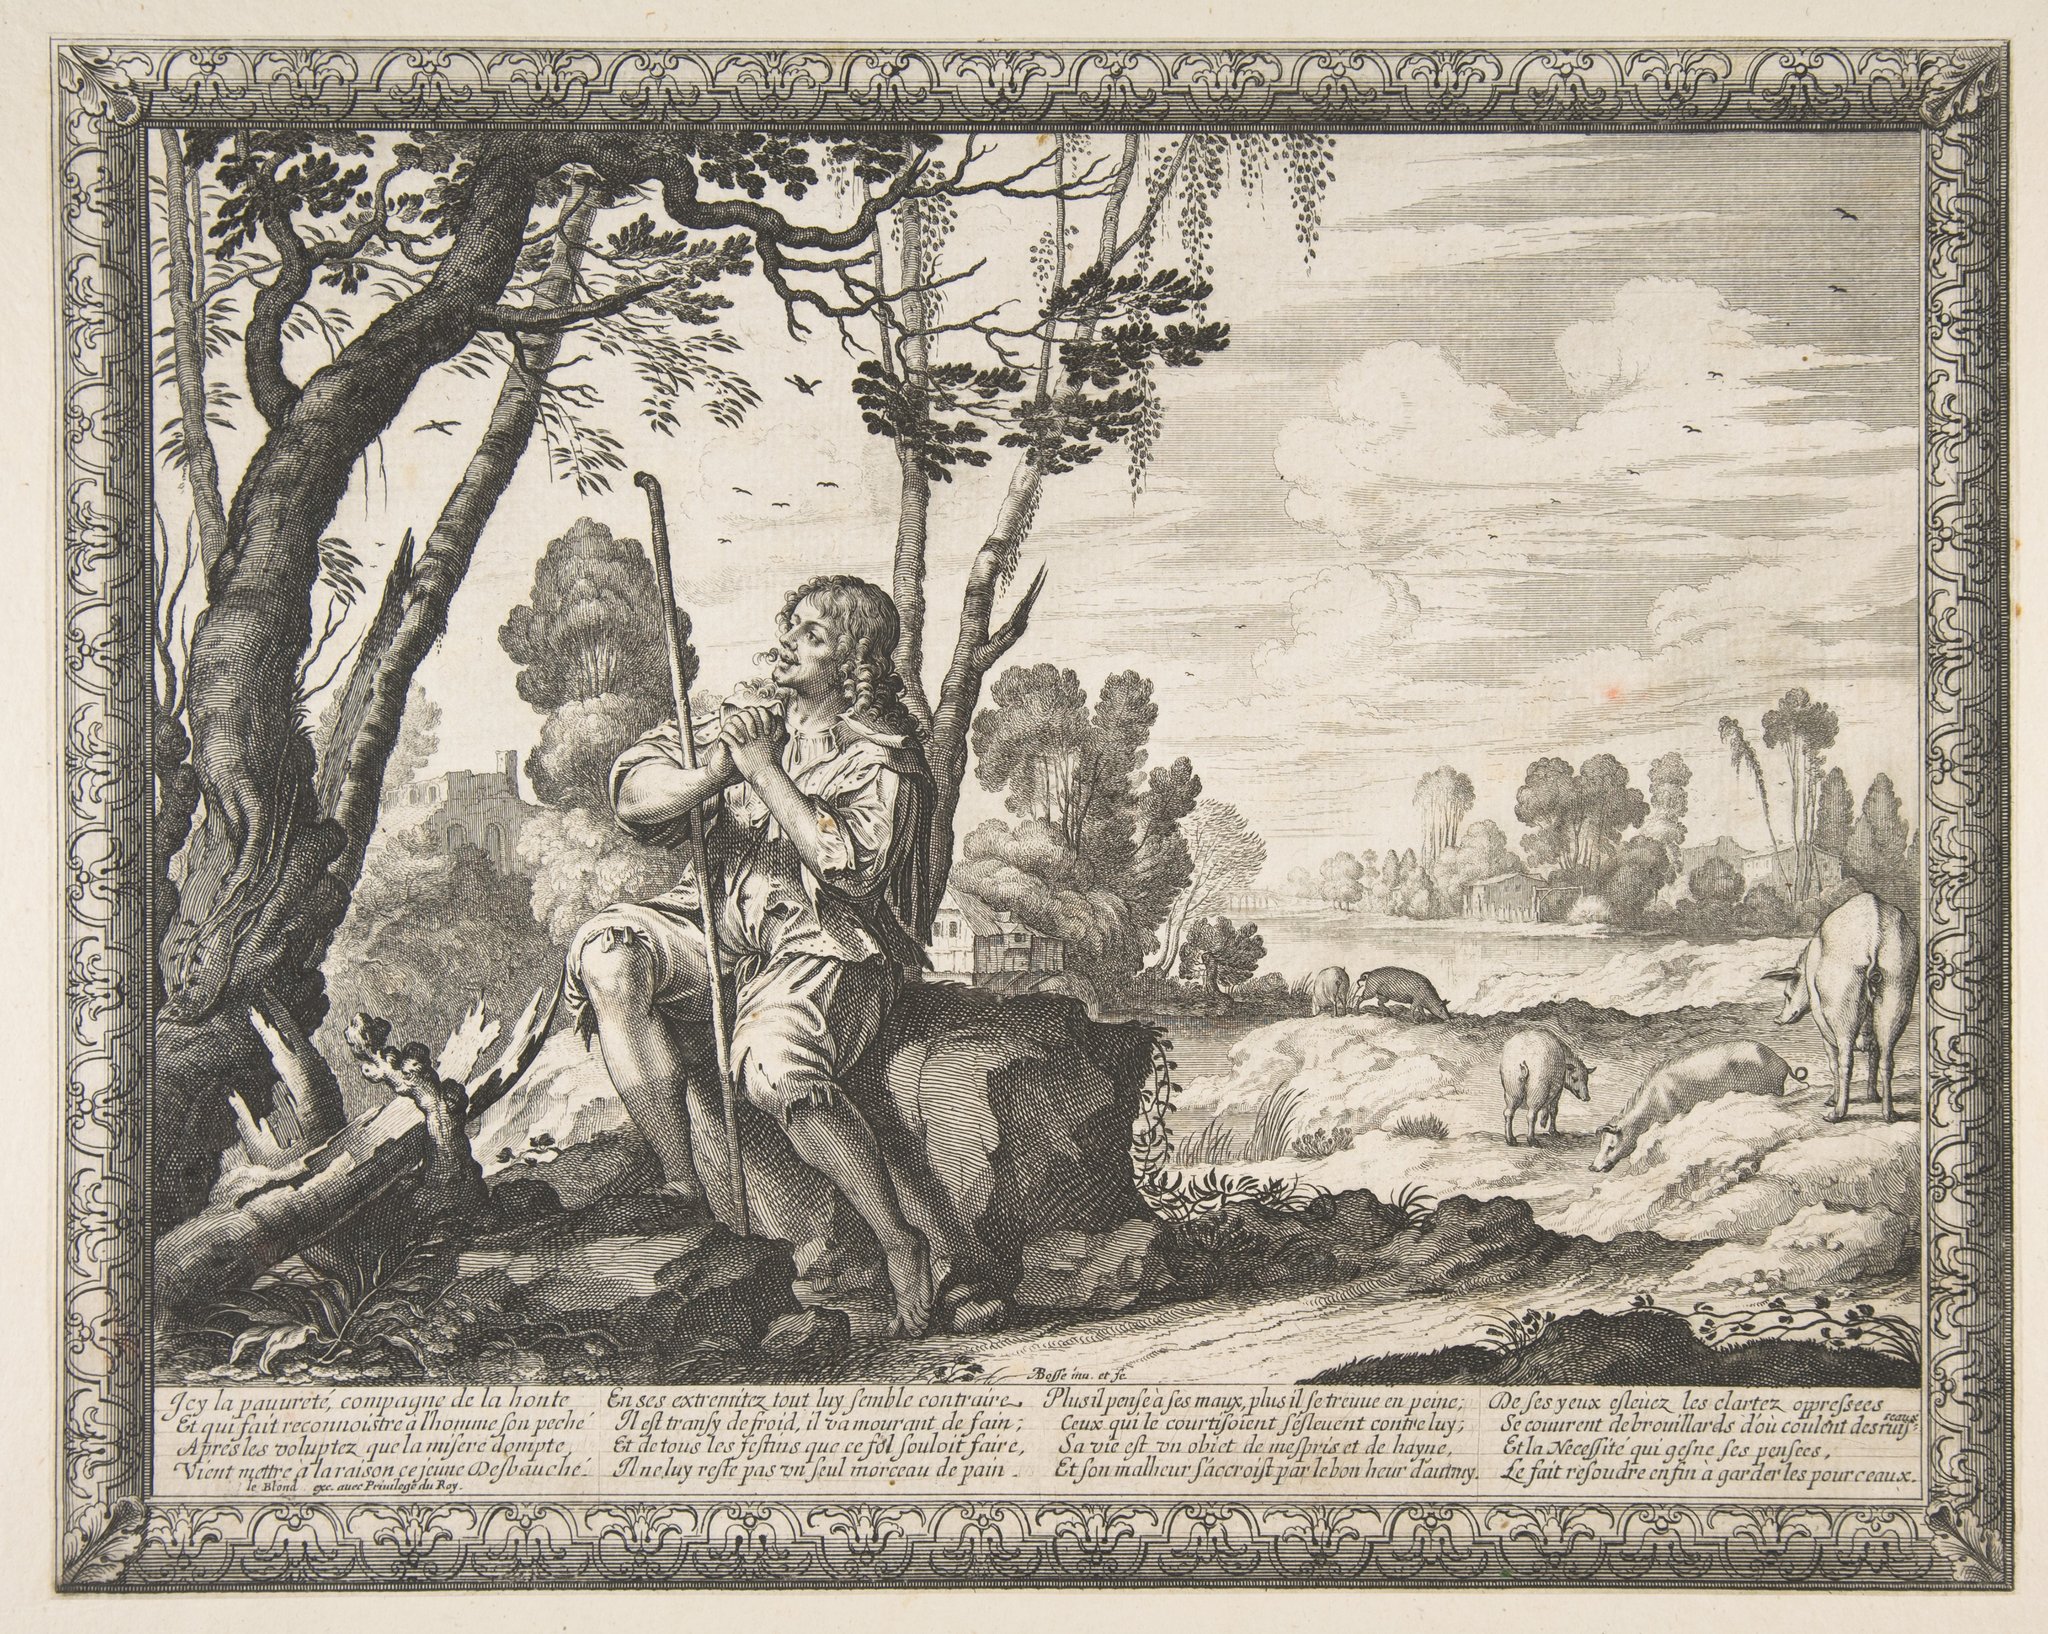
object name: print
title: The Prodigal Son Guarding Pigs (L'Enfant prodigue garde les cochons)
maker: abraham bosse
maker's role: artist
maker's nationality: french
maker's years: 1602-1676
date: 1636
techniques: etching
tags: men,pigs,trees